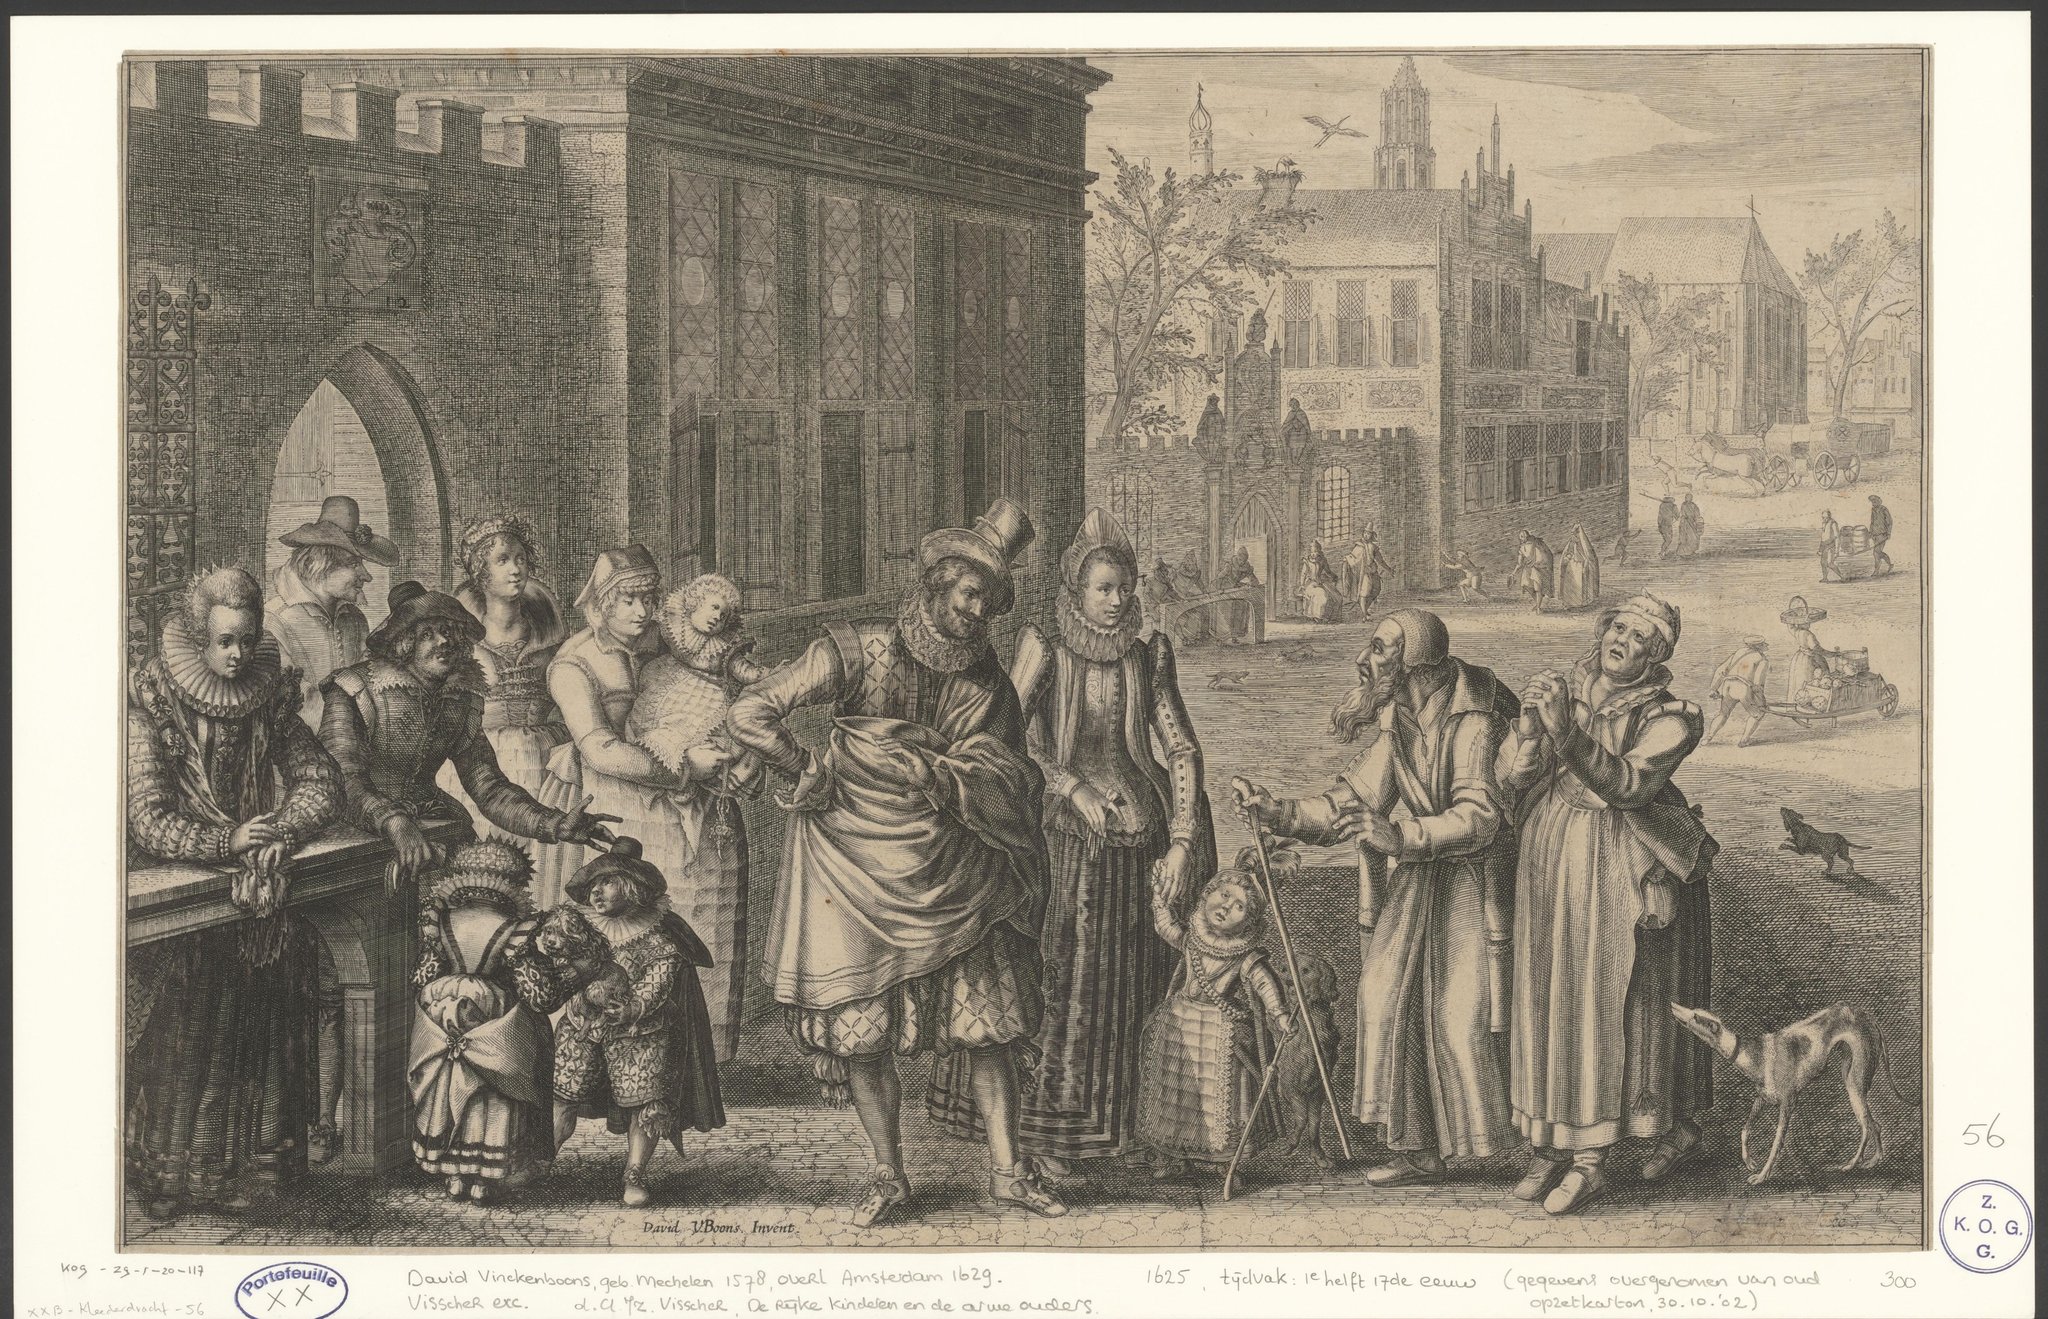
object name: print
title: Rijke kinderen, arme ouders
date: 1612-1652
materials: paper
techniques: engraving, etching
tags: poor parents, rich children (absence of filial love), street, dog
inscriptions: stamp, collector's mark: Lugt 963, collector's mark: Lugt 1641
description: De verarmde ouders, die voor hun kinderen gespaard hebben, kloppen nu, tevergeefs, bij hen aan om steun. De oude moeder maakt een smekend gebaar. De kinderen, staand voor hun prachtige huis, zijn rijk en naar de laatste mode gekleed. Op de achtergrond zijn huizen en een kerk te zien. Onderwerpsrubrieken binnen de Atlas Zeden en Gewoonten: Zeden en Gewoonten in Engeren Zin, De Kleeding, Kleederdrachten (tijdvakken), Het begin der 17de eeuw. (De Fransche mode).